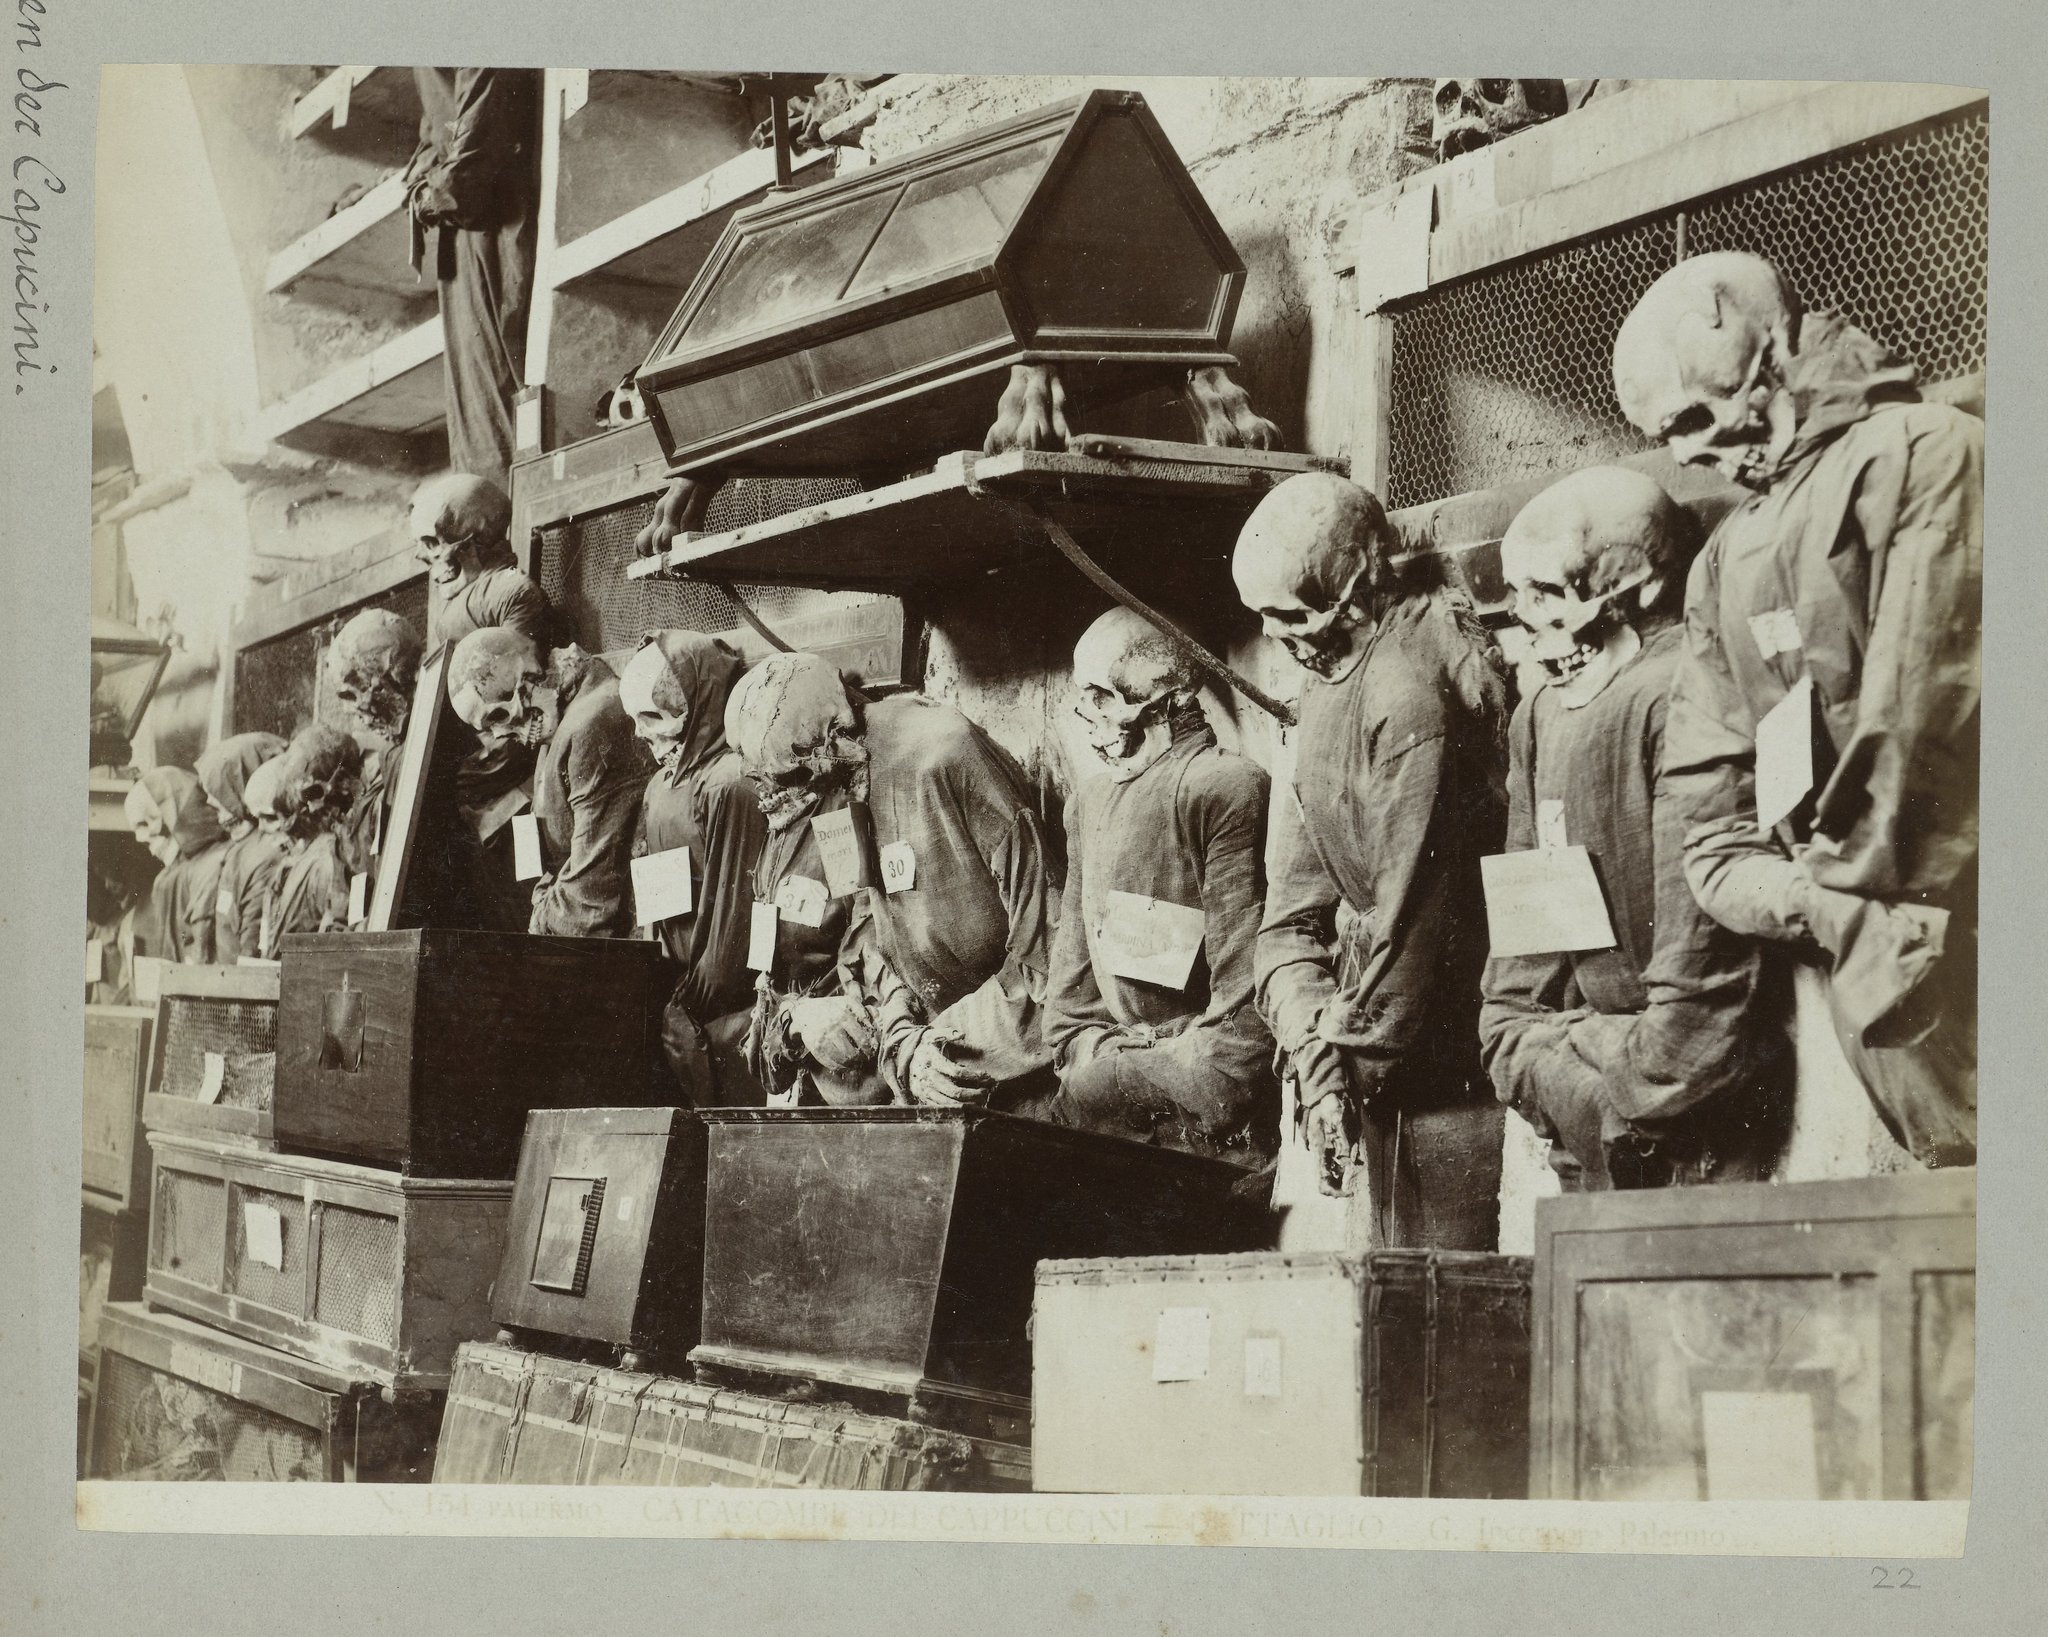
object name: photograph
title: N 154 Palermo, Catacomben del cappuccini, dettaglio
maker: giuseppe incorpora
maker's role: fotograaf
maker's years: 1834-1914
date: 1893-1903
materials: cardboard, photographic support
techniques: albumen print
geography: netherlands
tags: palermo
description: De catacomben der Capucijner monniken met aan de zijwanden van de catacomben de lichamen van overleden monniken.